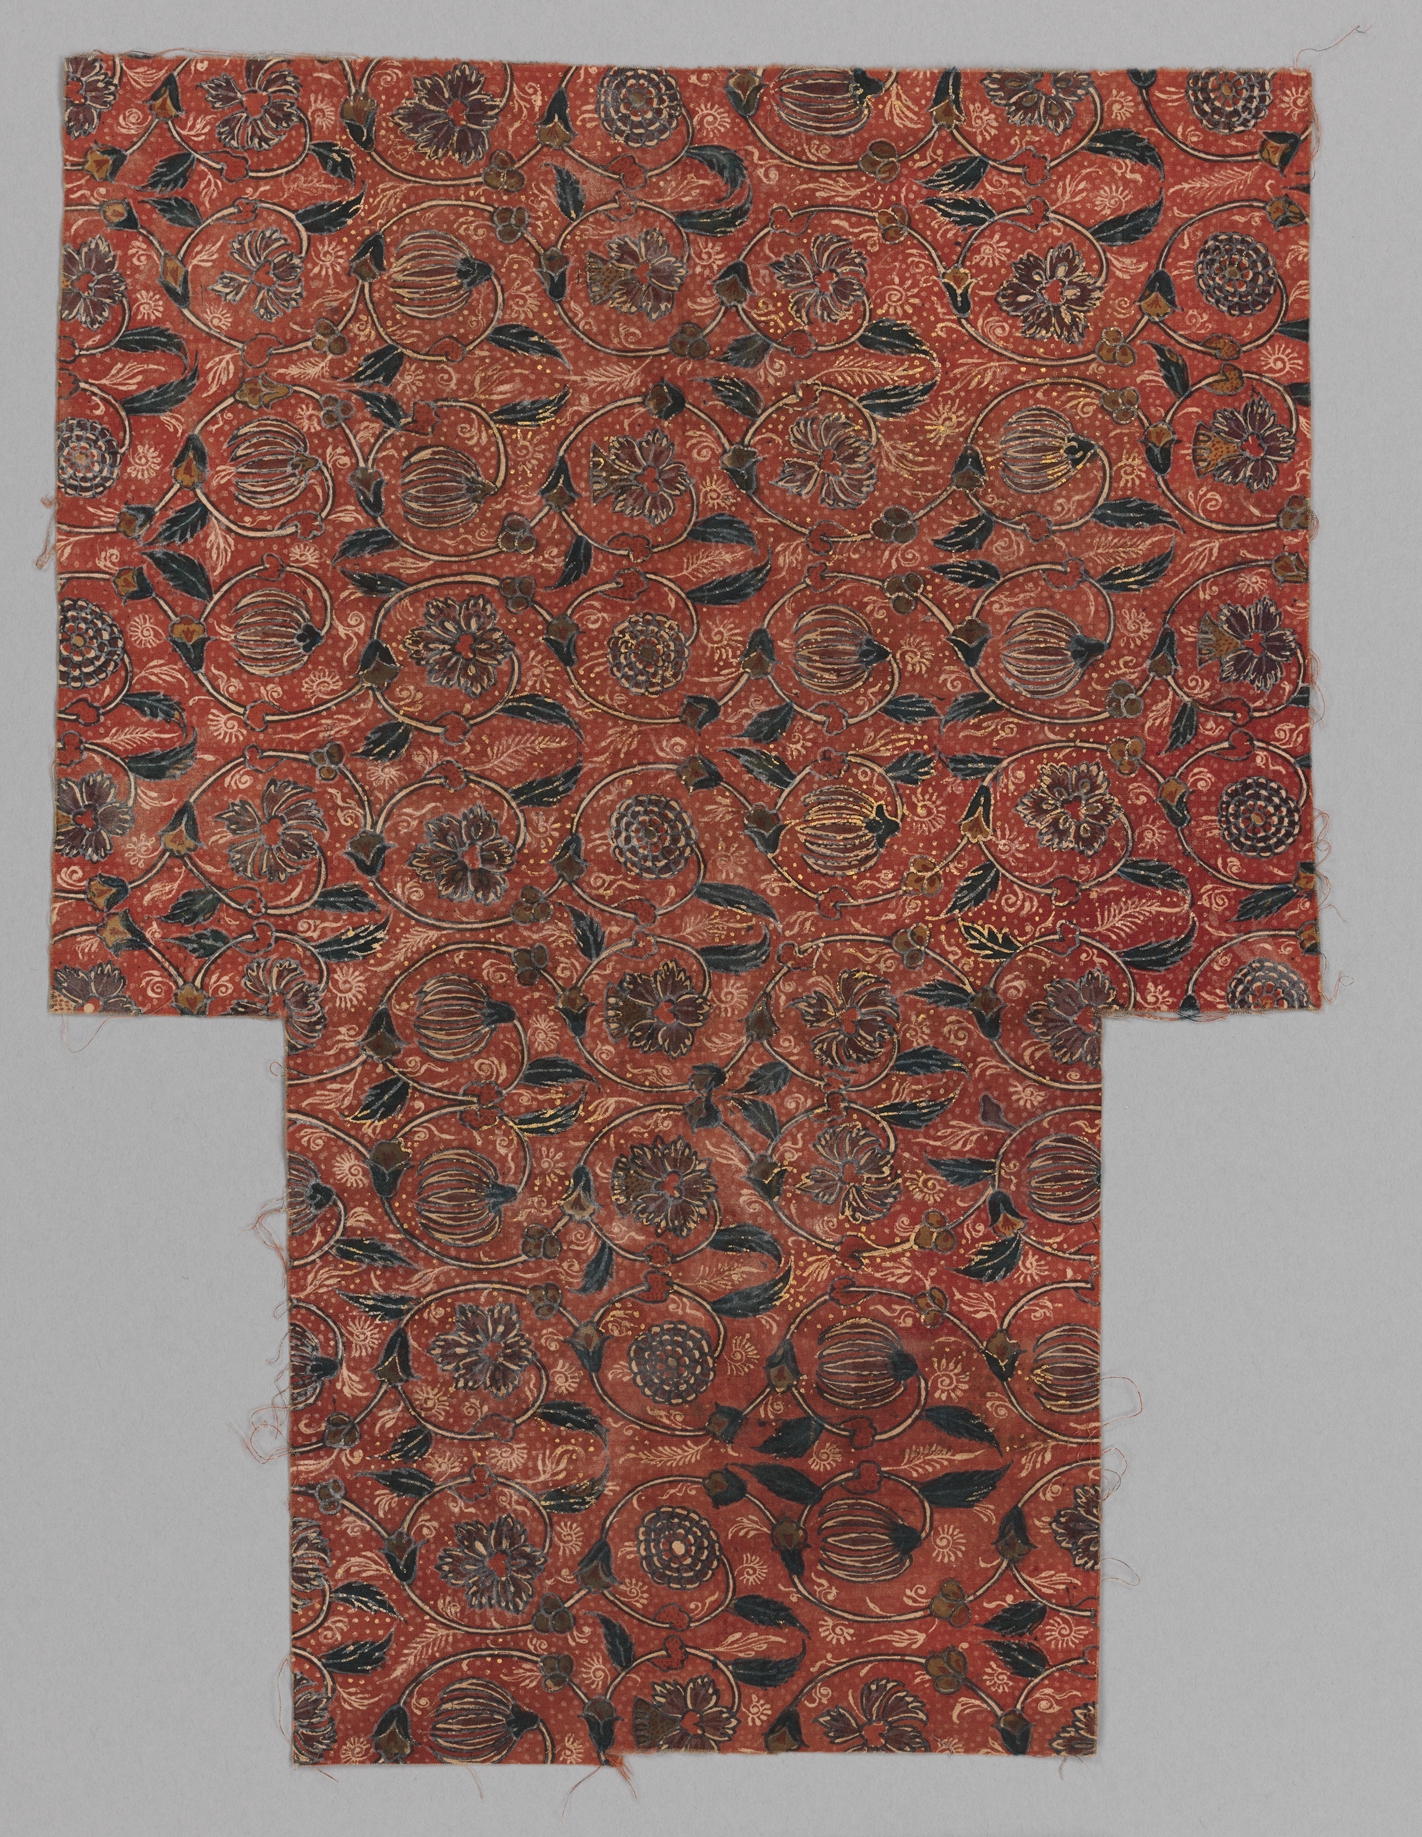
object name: sarasa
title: Sarasa with Gilded Floral Pattern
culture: indian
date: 1701-1750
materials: cotton, gold leaf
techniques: dyeing, painting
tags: flowers